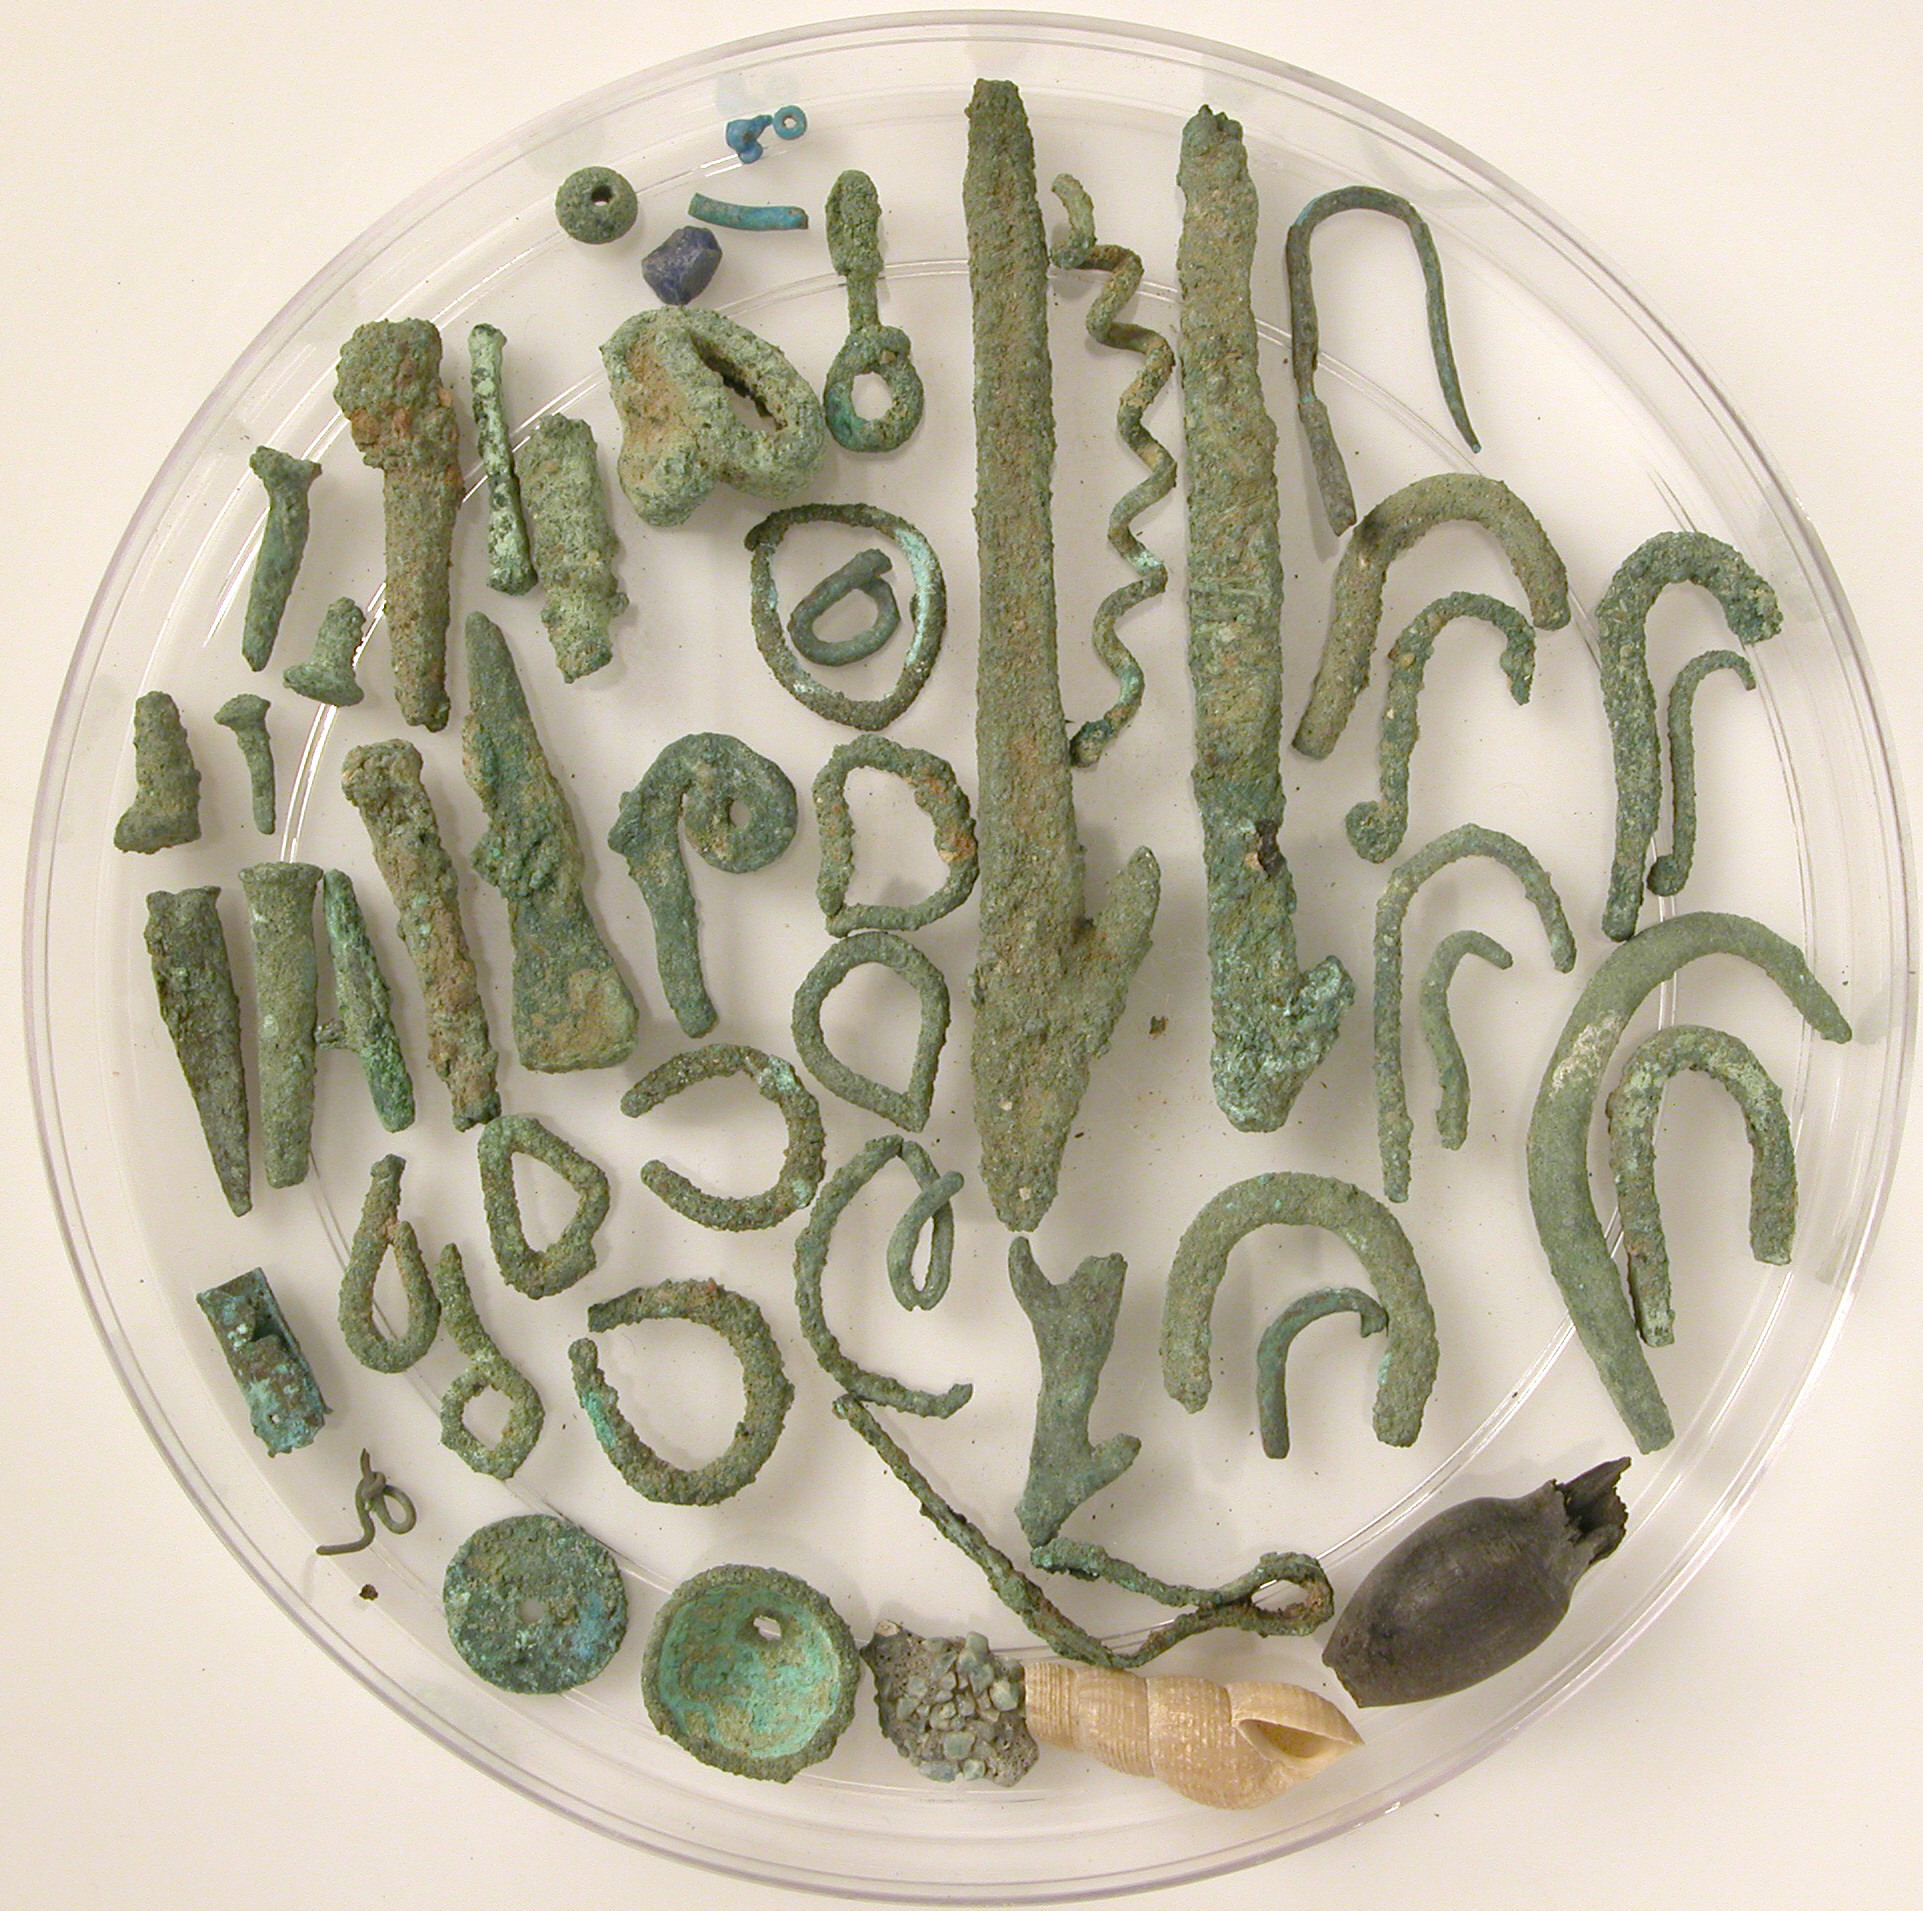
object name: fragment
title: Fragments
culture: coptic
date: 301-700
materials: copper alloy, earthenware, glass, shell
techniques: glazing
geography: egypt